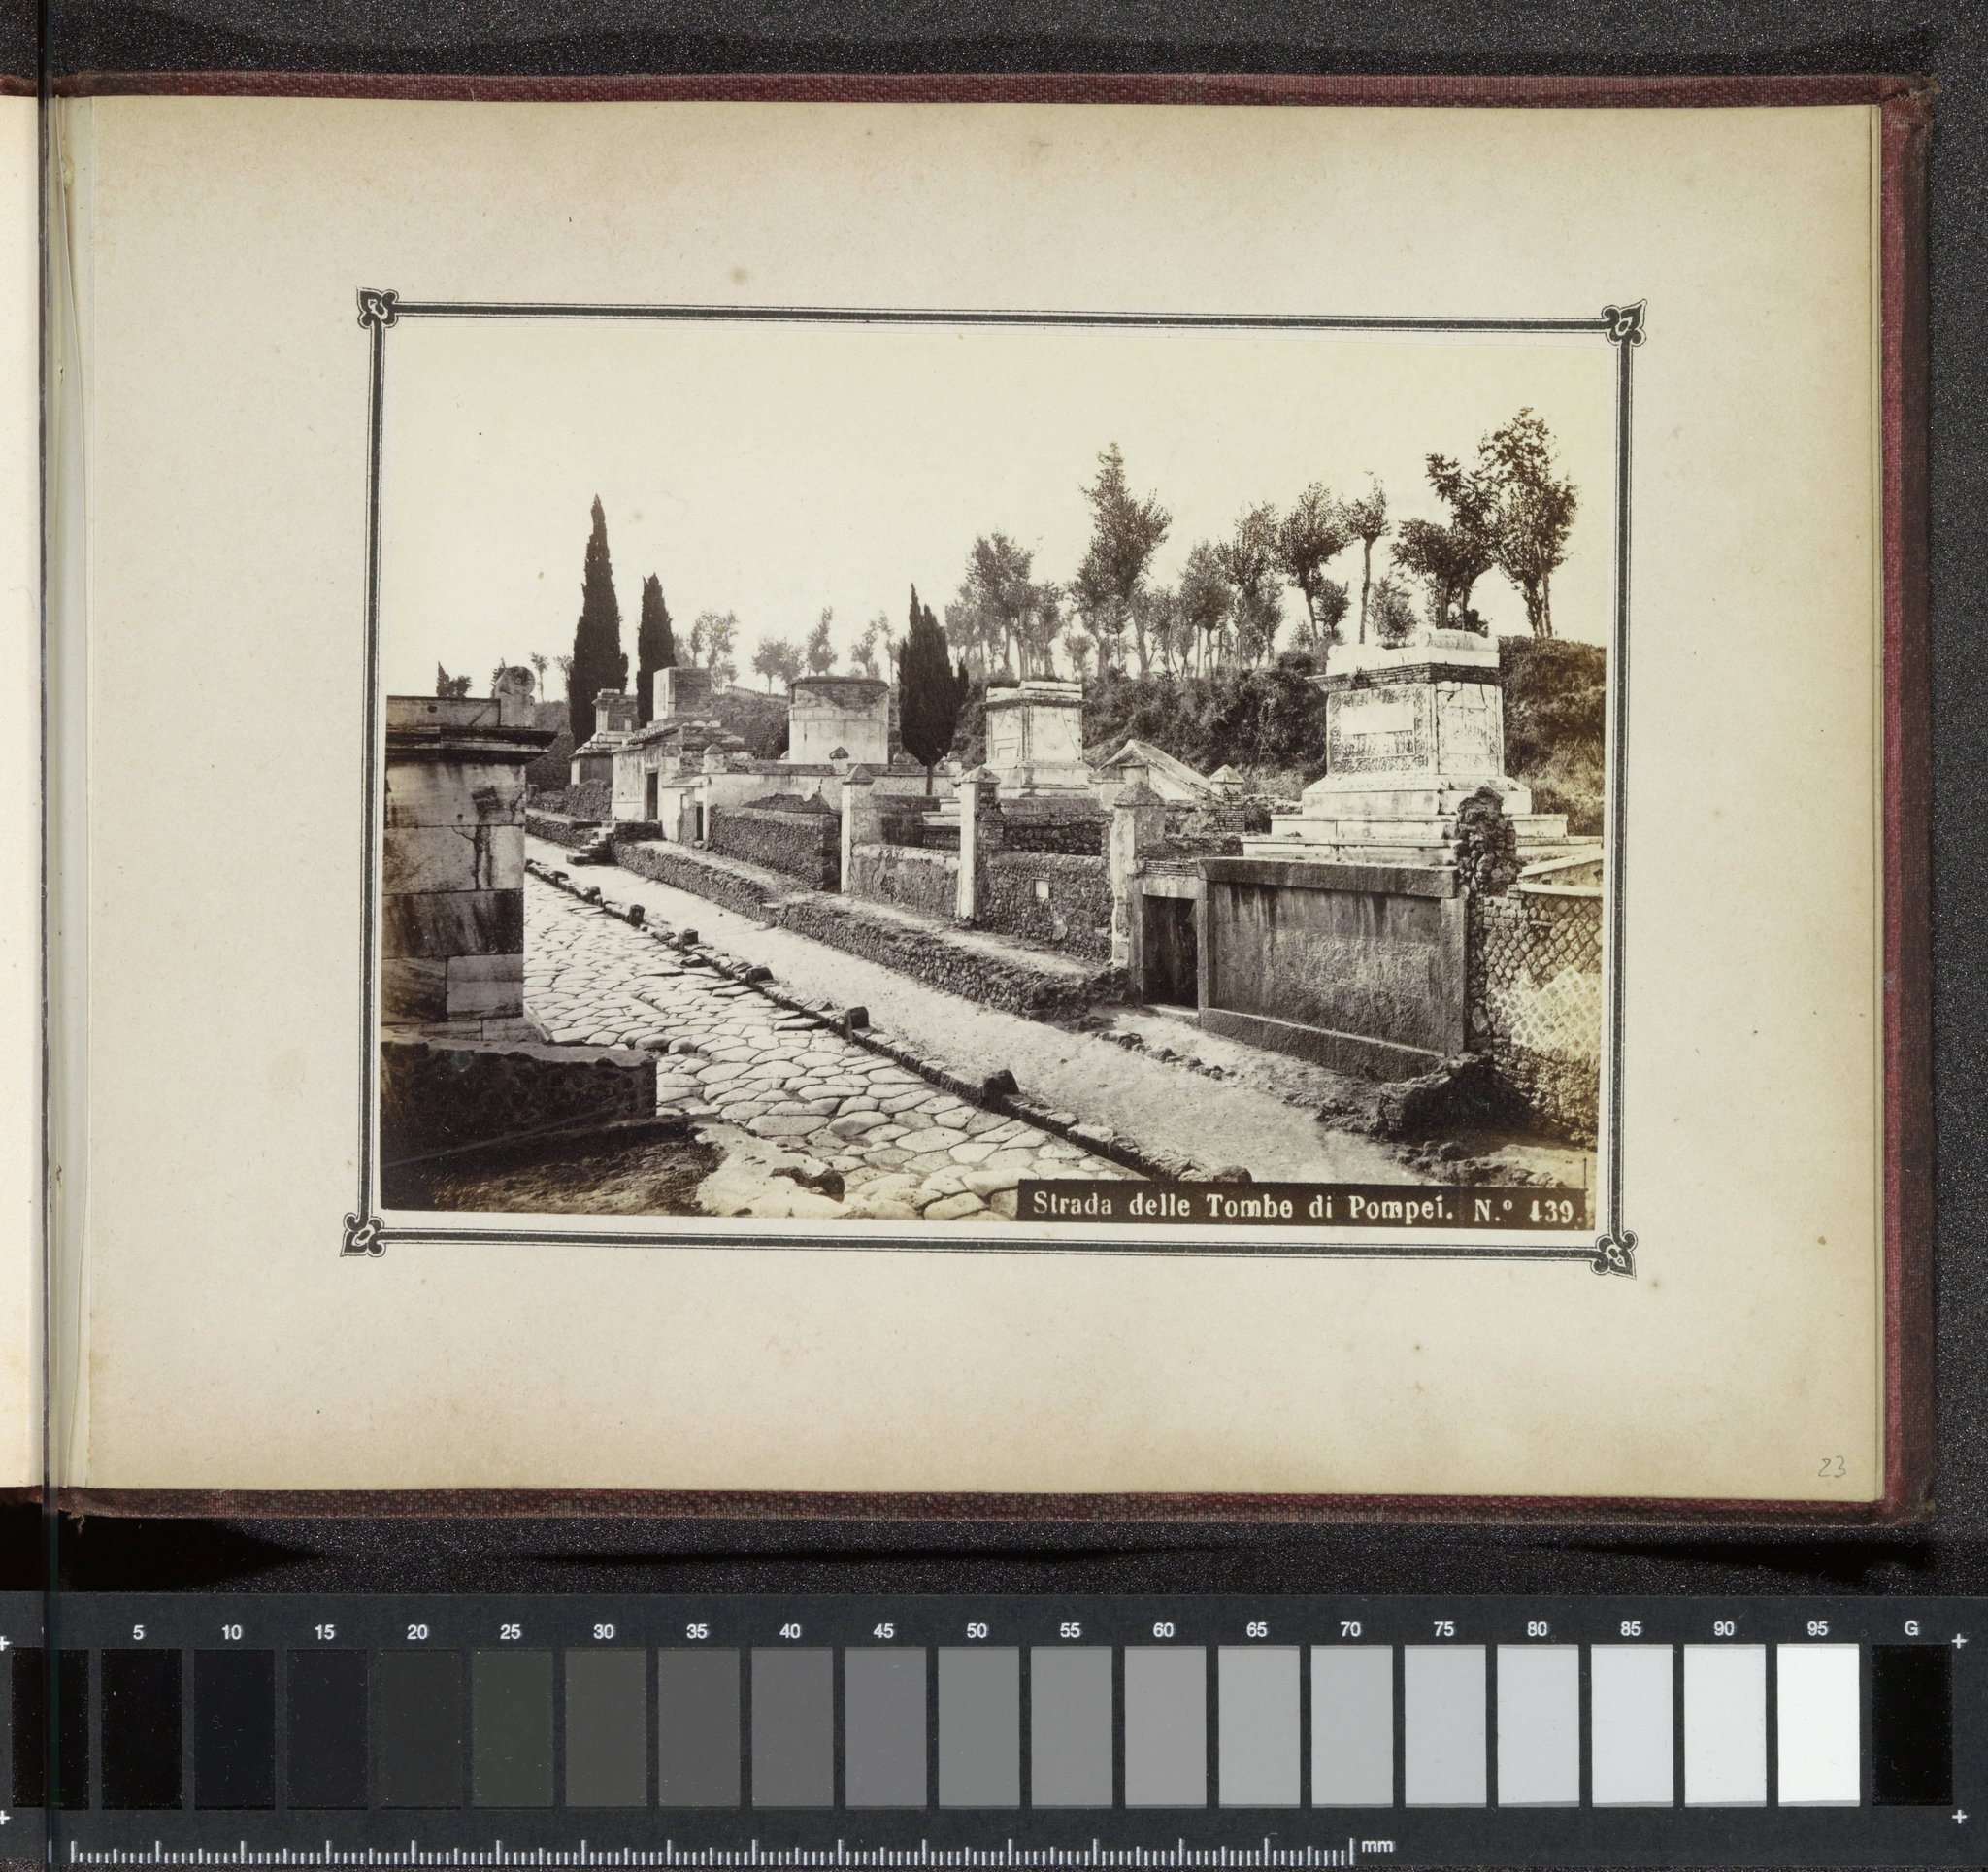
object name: album leaf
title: Strada delle Tombe di Pompei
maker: roberto rive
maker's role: fotograaf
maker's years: 1825-1868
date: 1860-1900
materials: paper, photographic support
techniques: albumen print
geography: pompeii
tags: grave, tomb, excavation ~ archaeology, street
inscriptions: number: ‘439’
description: Onderdeel van Fotoalbum met opnames van opgravingen in Pompeï door Roberto Rive.